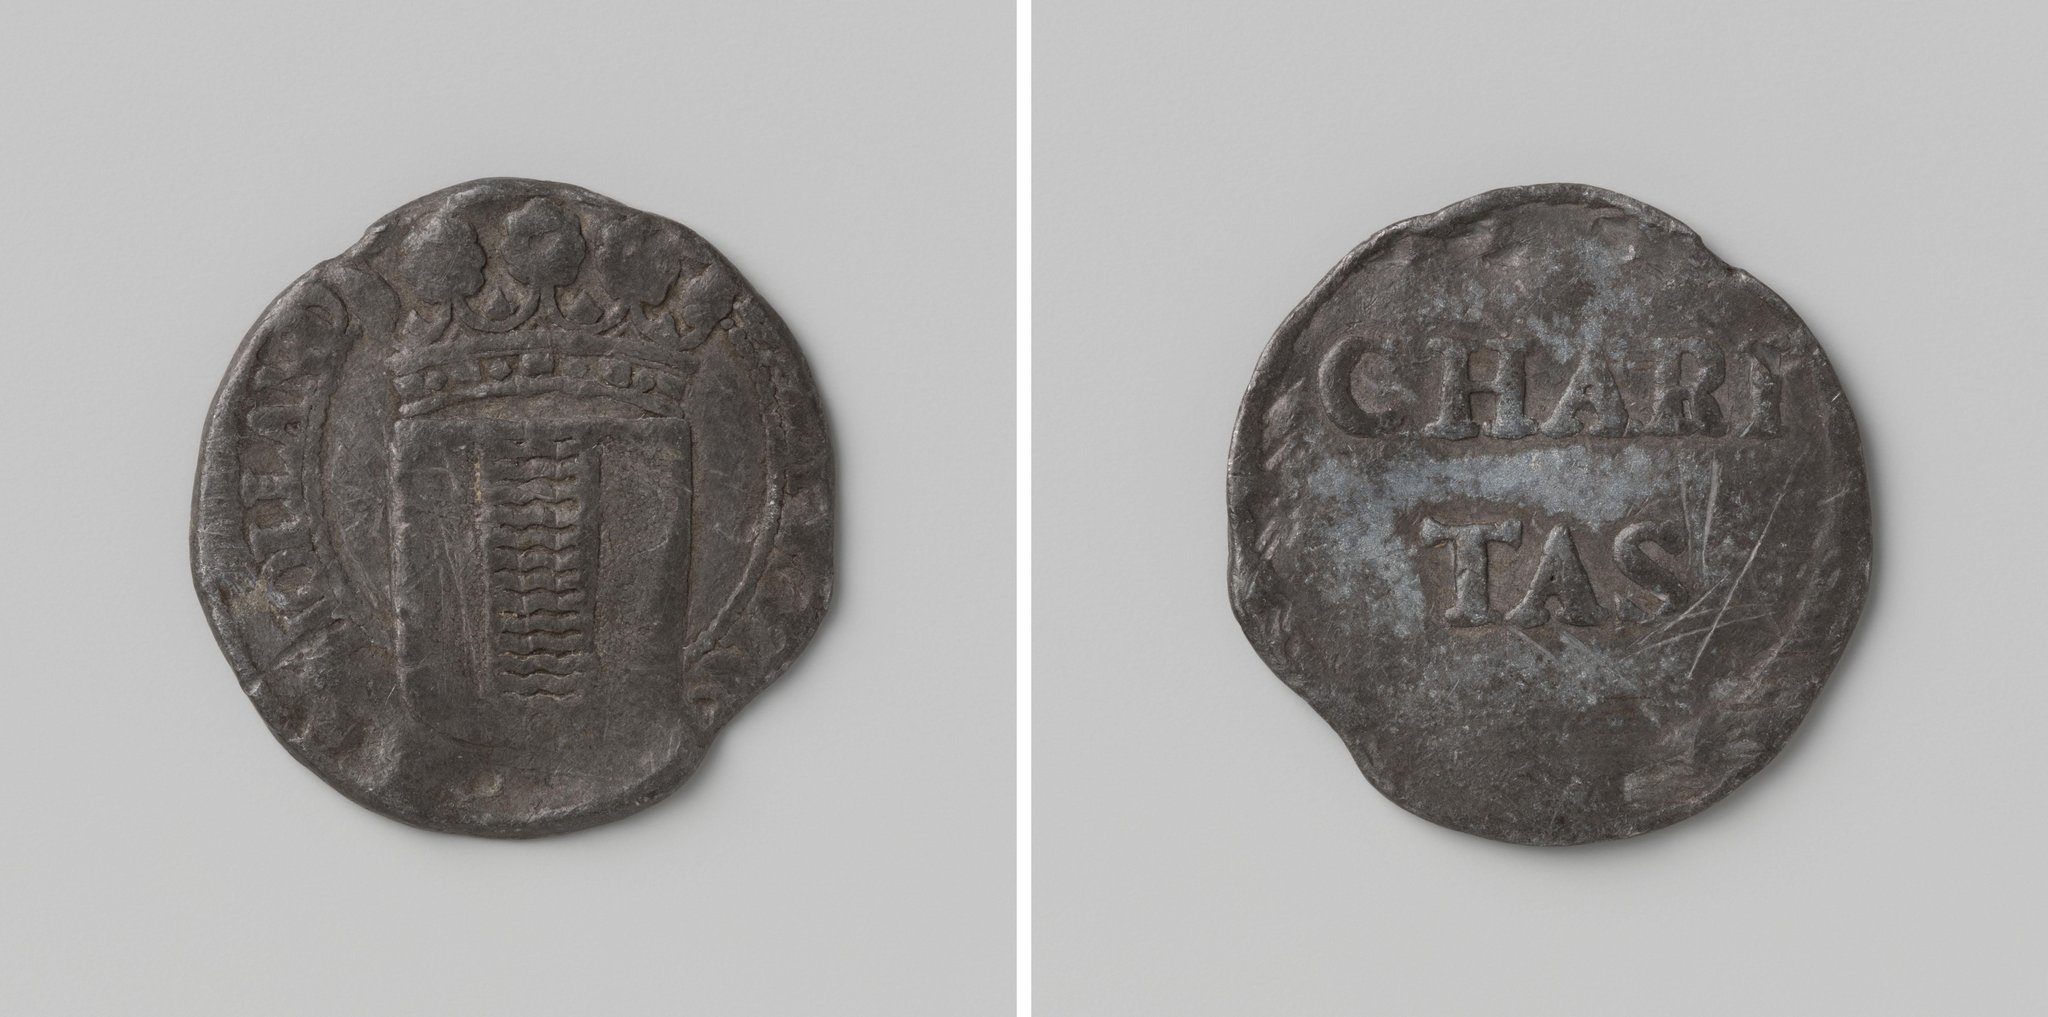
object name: armenloodje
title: Charitatenhuis te Delft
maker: Anonymous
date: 1600-1700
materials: lead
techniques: casting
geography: delft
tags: delft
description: Loden penning. Voorzijde: gekroond wapenschild binnen omschrift. Keerzijde: opschrift